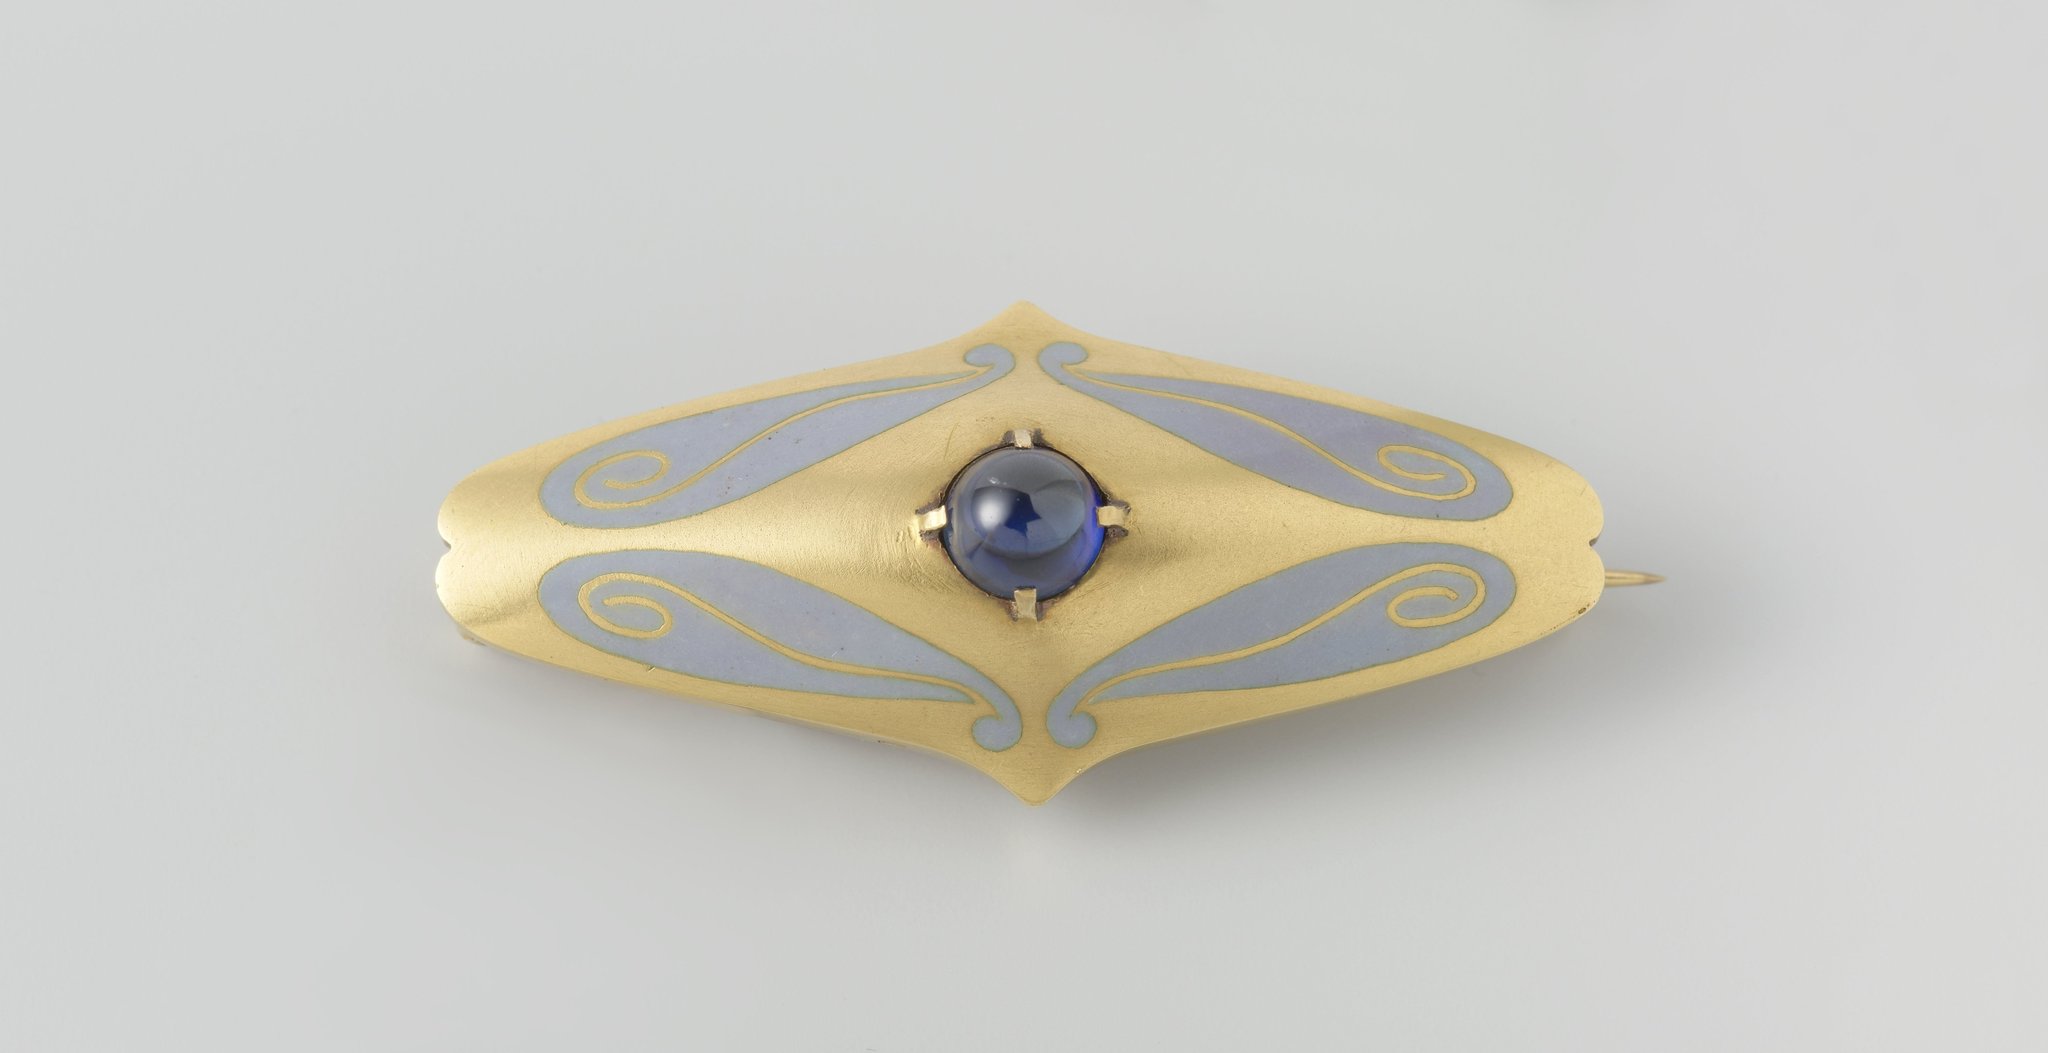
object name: jewellery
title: Broche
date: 1908-1911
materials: gold, gemstone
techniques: enameling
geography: amsterdam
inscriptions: alloy mark, alloy mark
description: Jewellery. Gold, silver, enamel and semi-precious stones. Amsterdam, c. 1908 - 1911, by L.W. van Kooten, designed by Bert Nienhuis. Given by the Prins Bernhard Fonds, 1980.